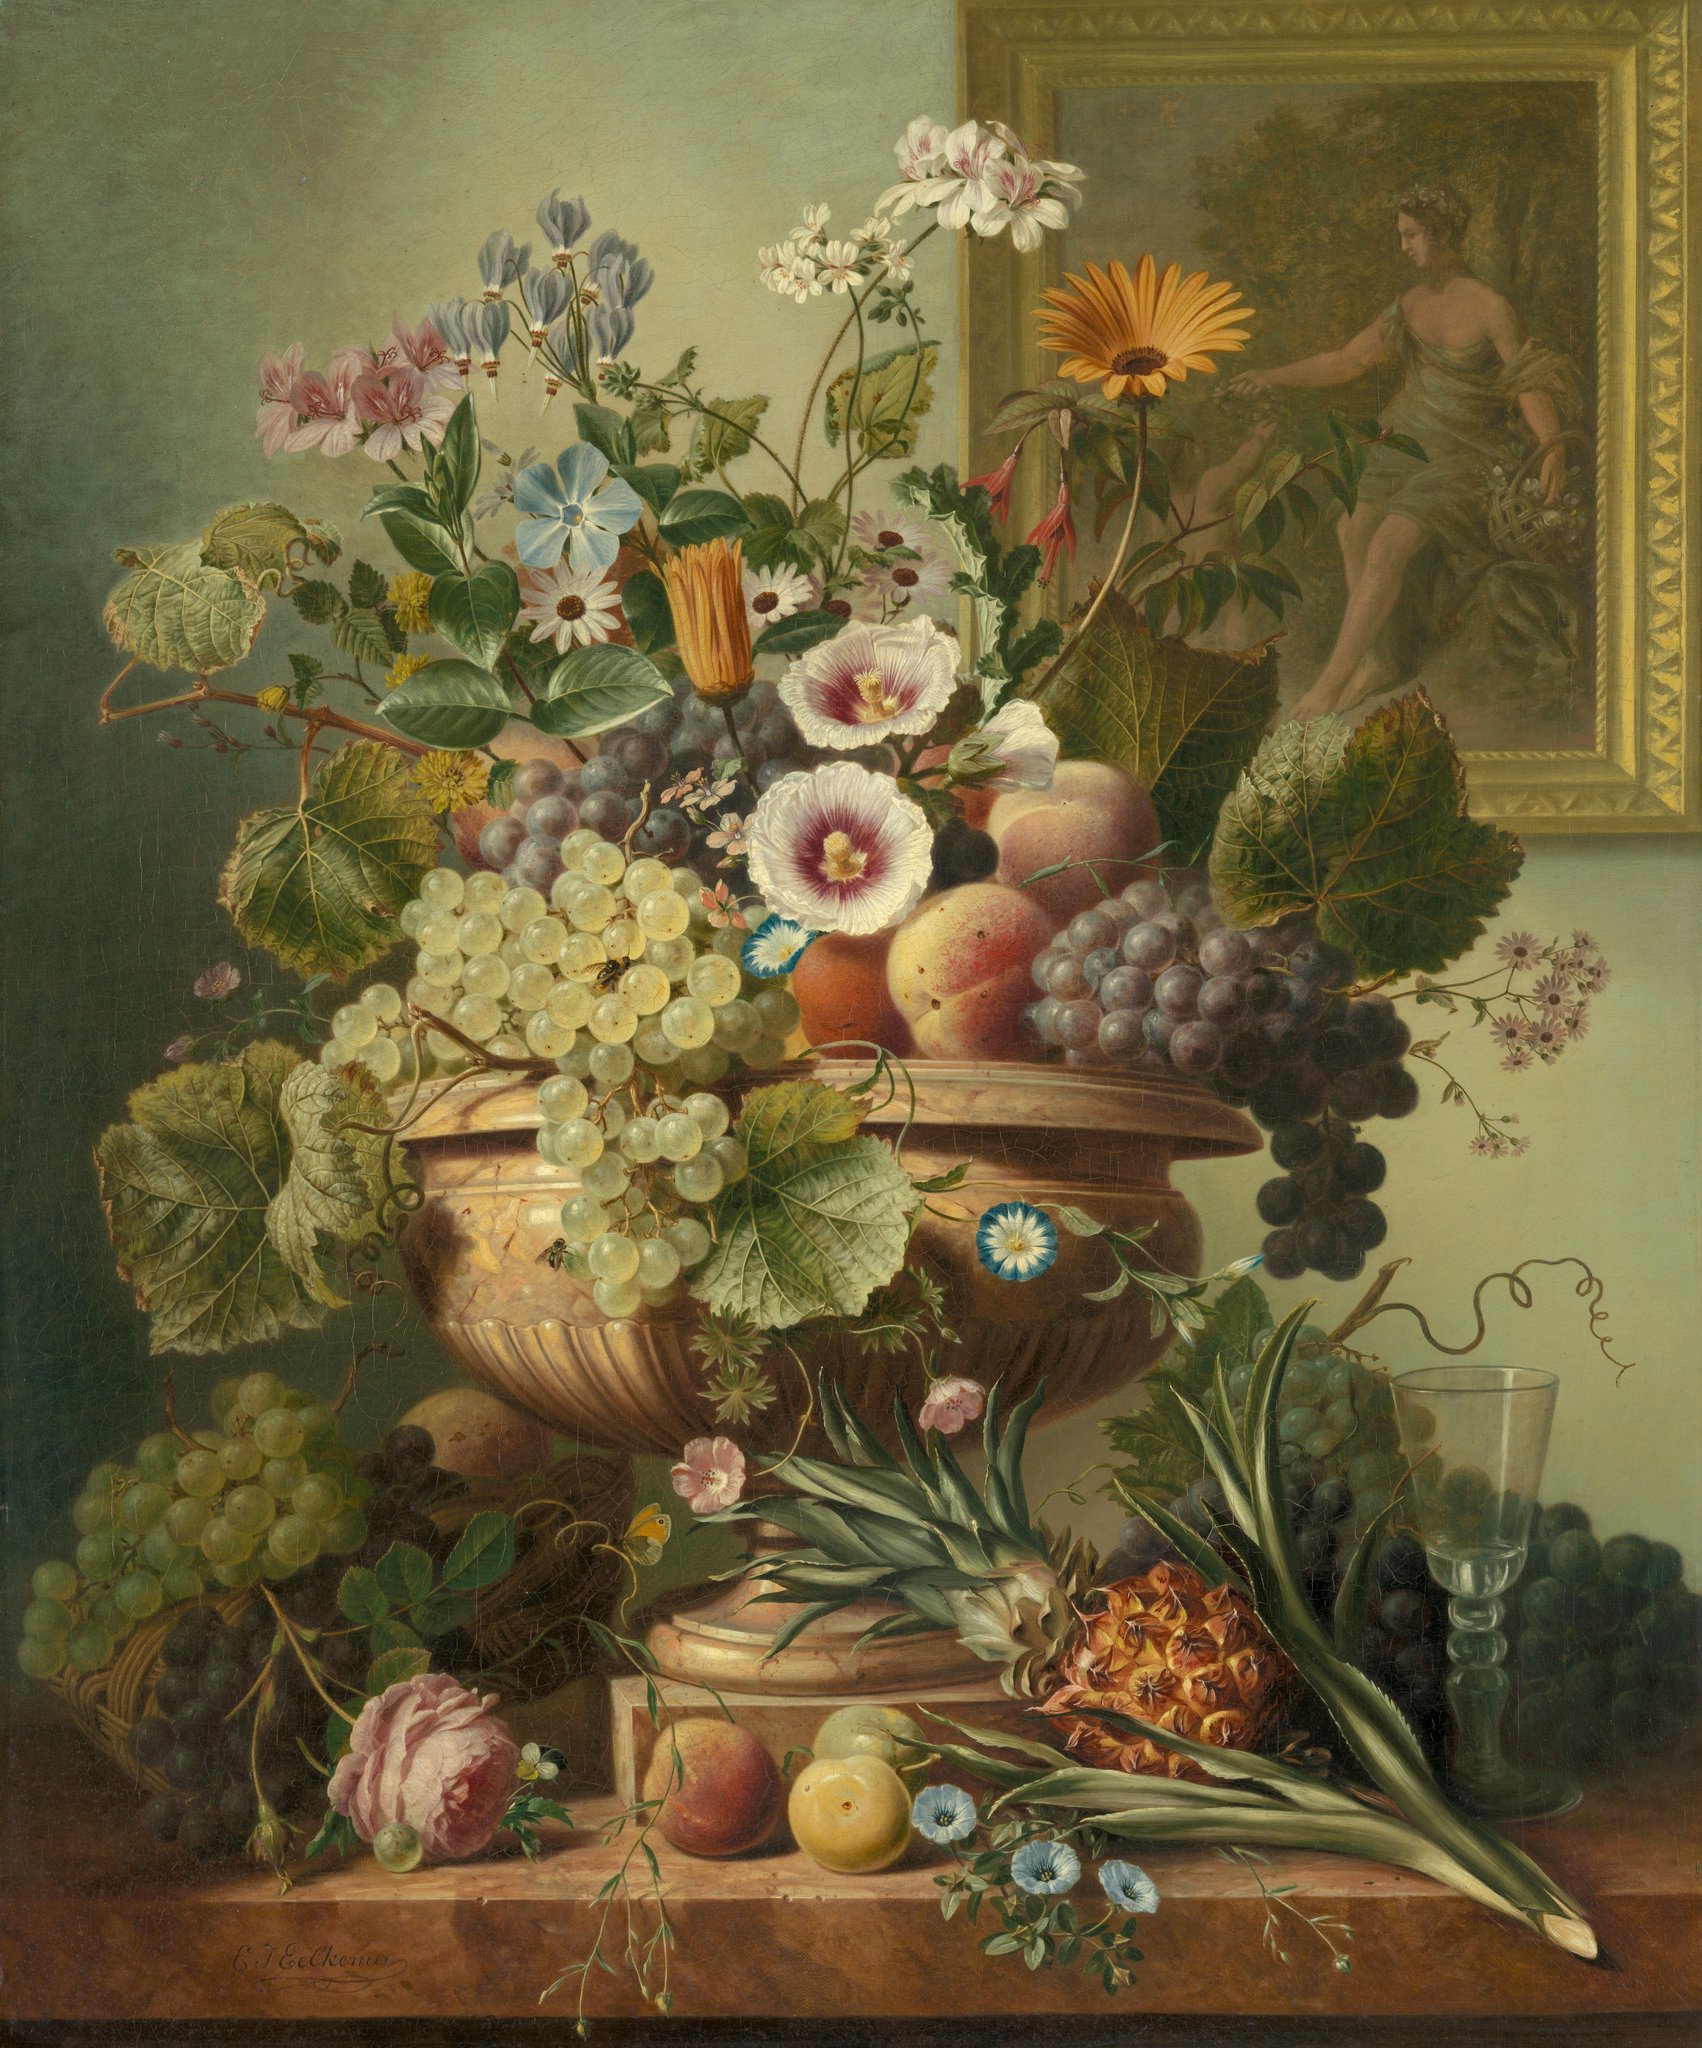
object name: painting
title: Still Life with Flowers and Fruit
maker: eelke jelles eelkema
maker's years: 1788-1839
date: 1815-1830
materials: canvas, oil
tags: still life of plants, flowers and fruit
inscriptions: signature: ‘E.J. Eelkema’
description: Stilleven met bloemen en vruchten. Op een plint staat een stenen vaas met bloemen, vruchten en wijnranken. Op de plint staat een glas en liggen een ananas, perziken, druiven en een roos. Aan de muur hangt een schilderij van een vrouw met een bloemenmand die een kind een bloemenkrans aanreikt.